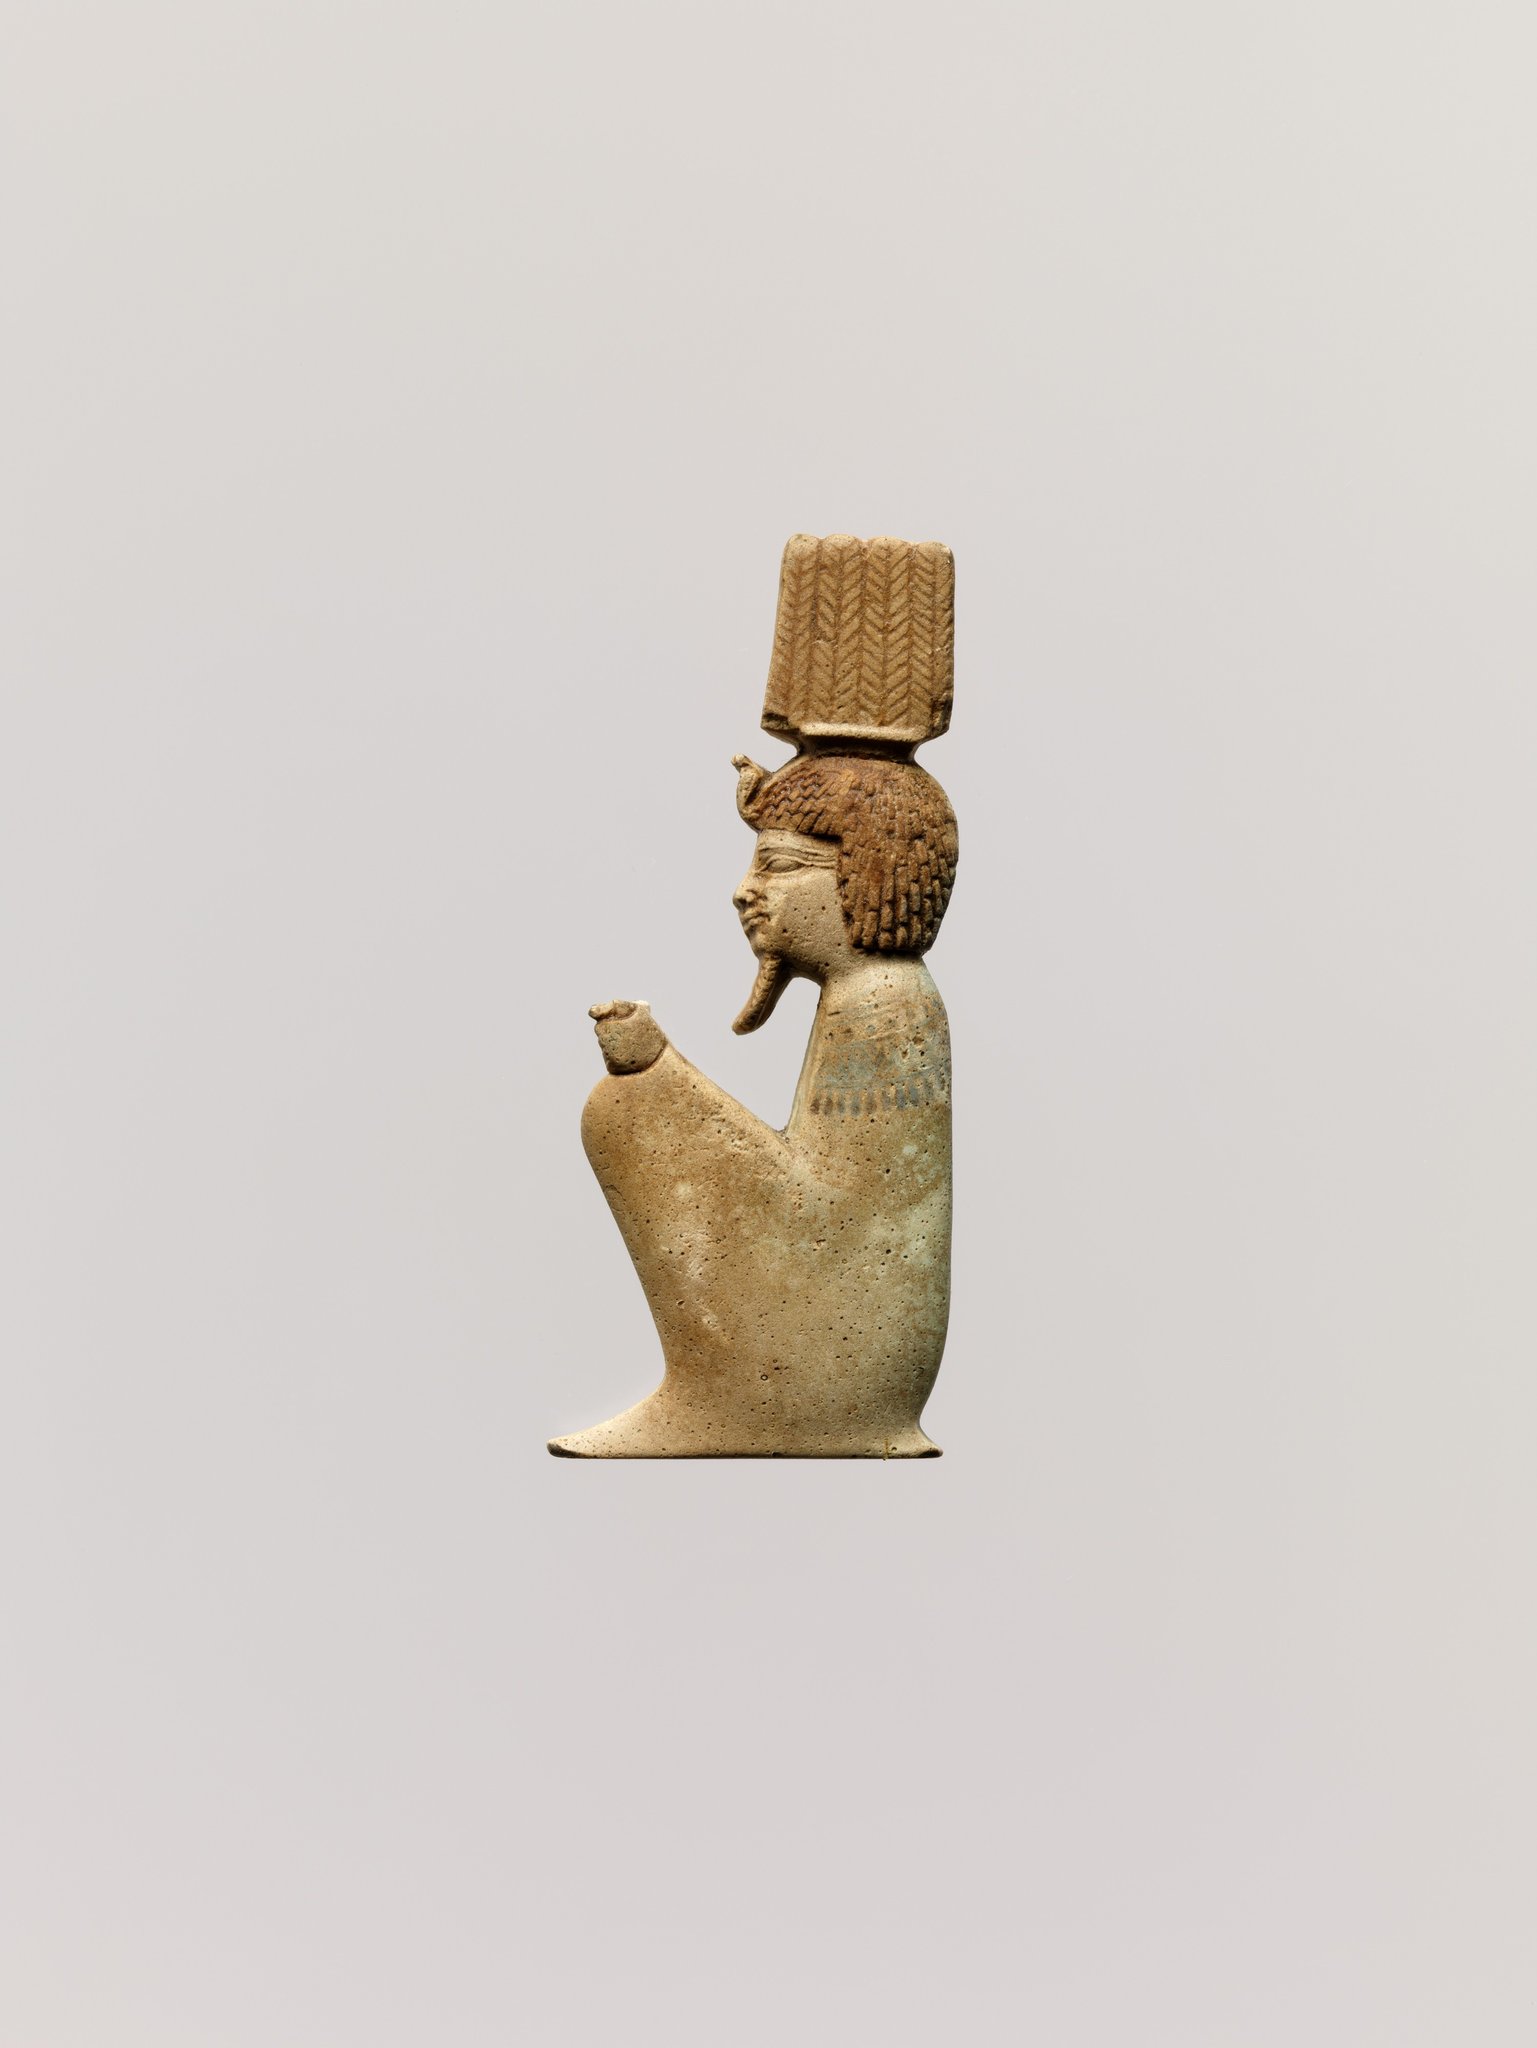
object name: inlay, squatting figure, anhur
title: Inlay depicting the squatting god Anhur (Onuris)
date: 400-301 BCE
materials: faience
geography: middle egypt